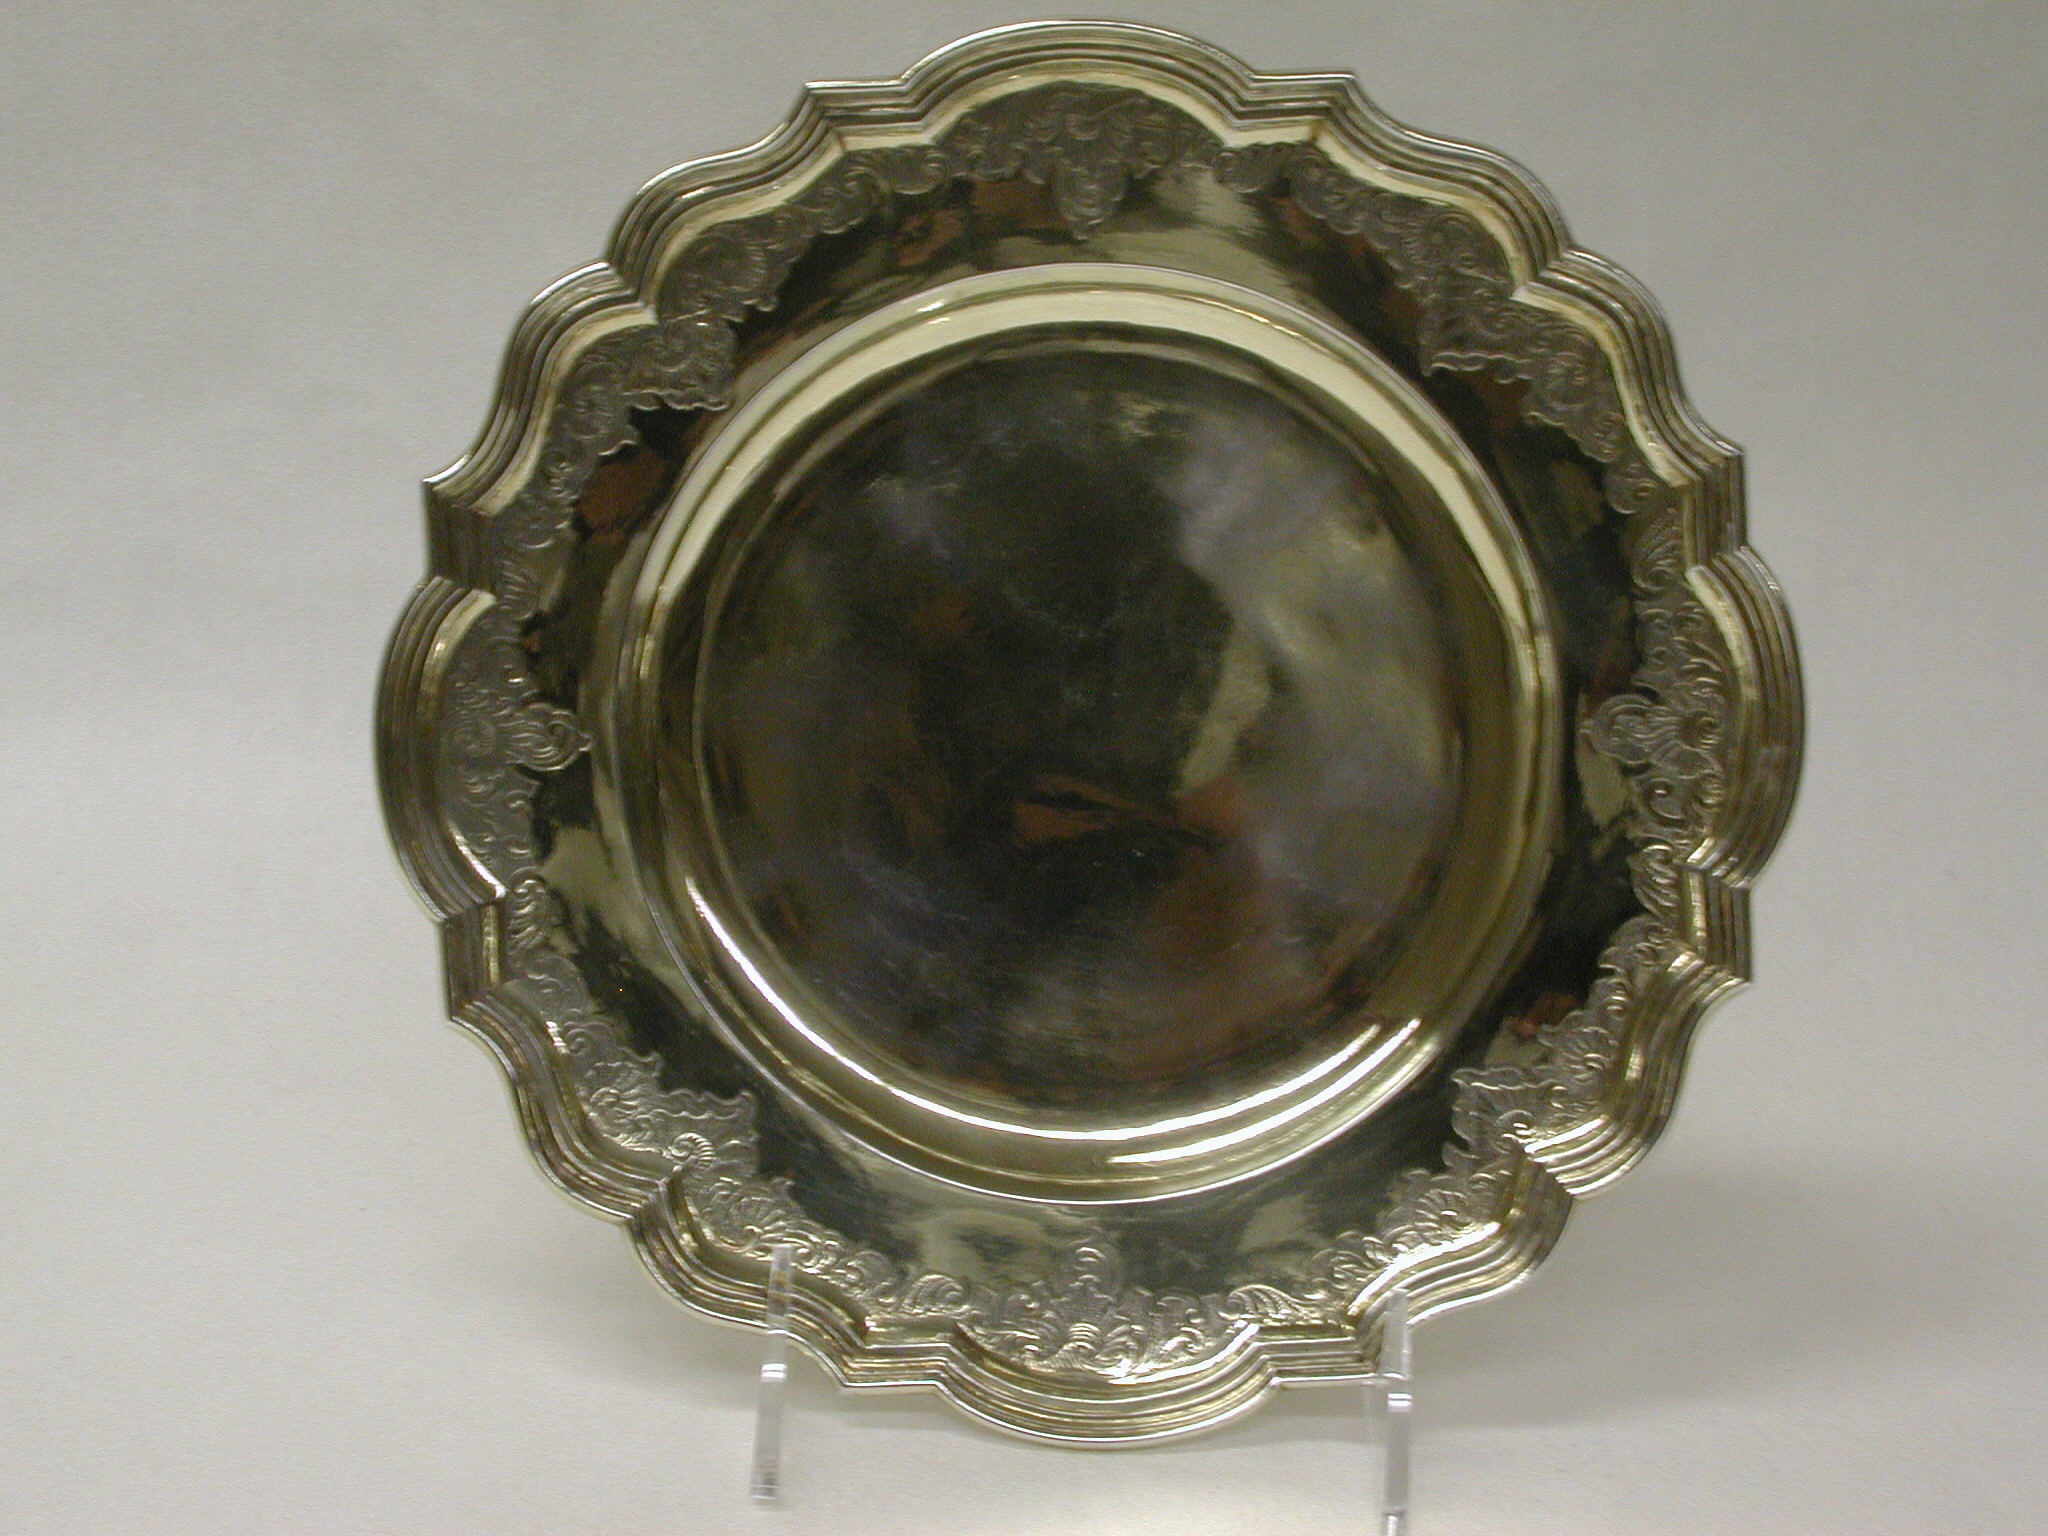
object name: écuelle stand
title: Stand for écuelle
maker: abraham drentwett iv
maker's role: maker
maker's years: 1711-1785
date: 1743-1745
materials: silver gilt